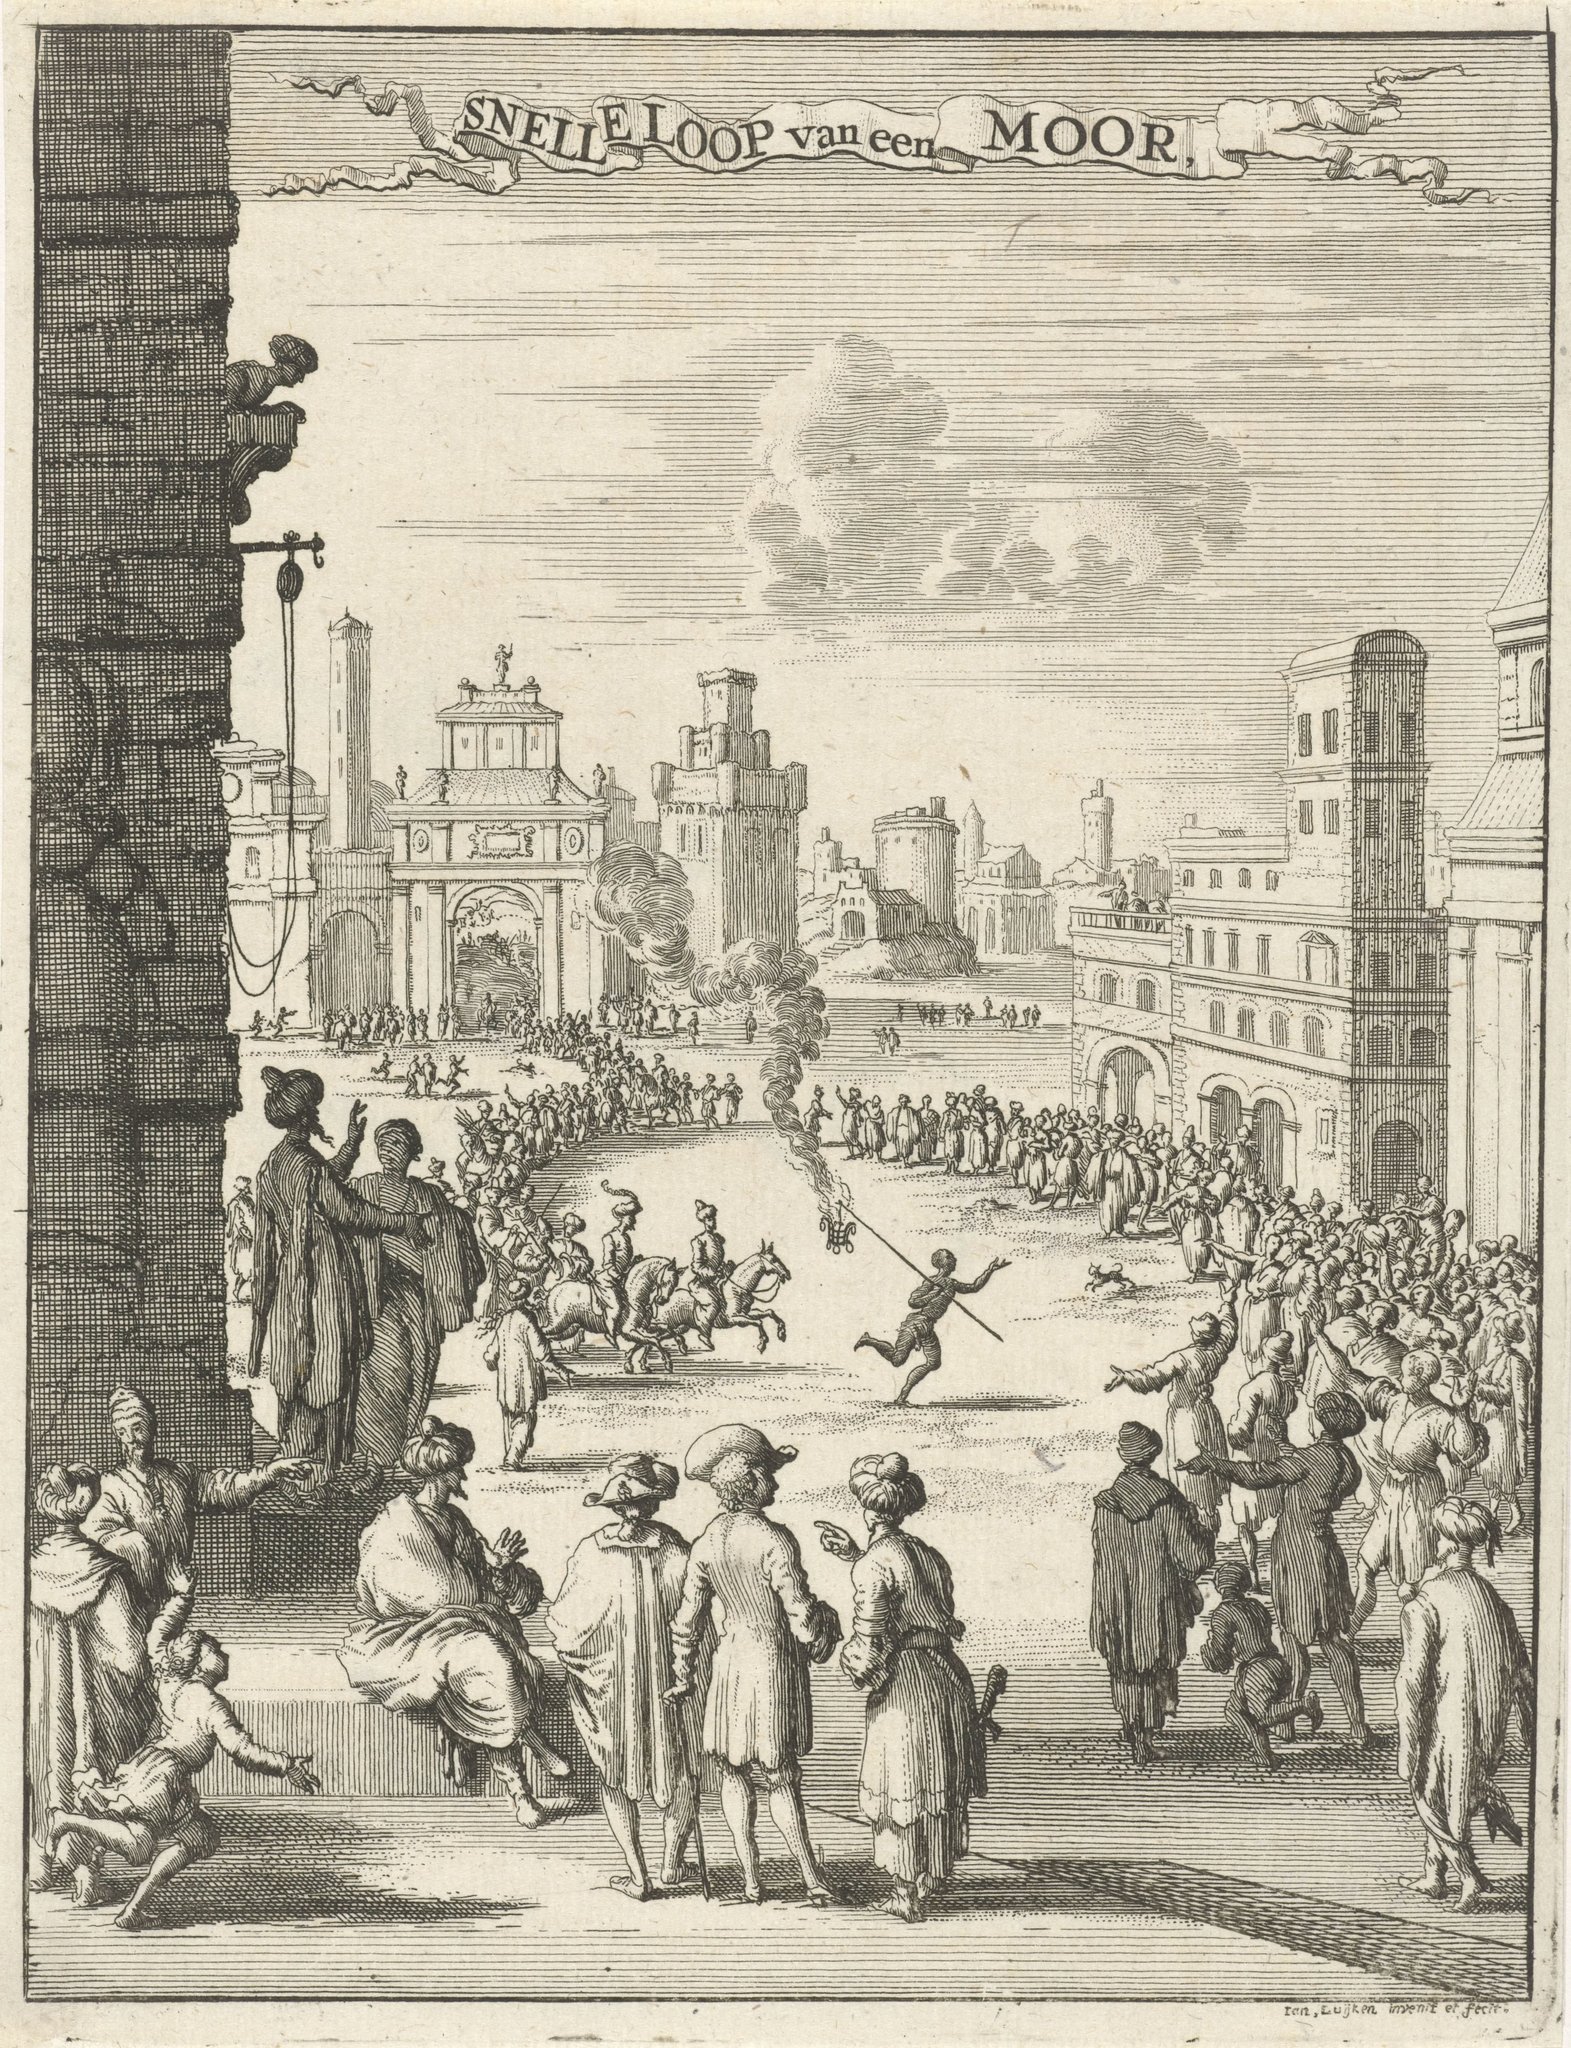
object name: print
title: Snelle Loop van een Moor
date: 1681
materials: paper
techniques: etching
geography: amsterdam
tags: europeans, asiatic races and peoples, square, place, circus, etc., africans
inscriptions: collector's mark: Lugt 2228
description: Illustratie opgenomen in: Melton, Edward. Zeldzaame en gedenkwaardige zee- en landreizen, p. 67. Amsterdam: Jan Claesz ten Hoorn, 1681.